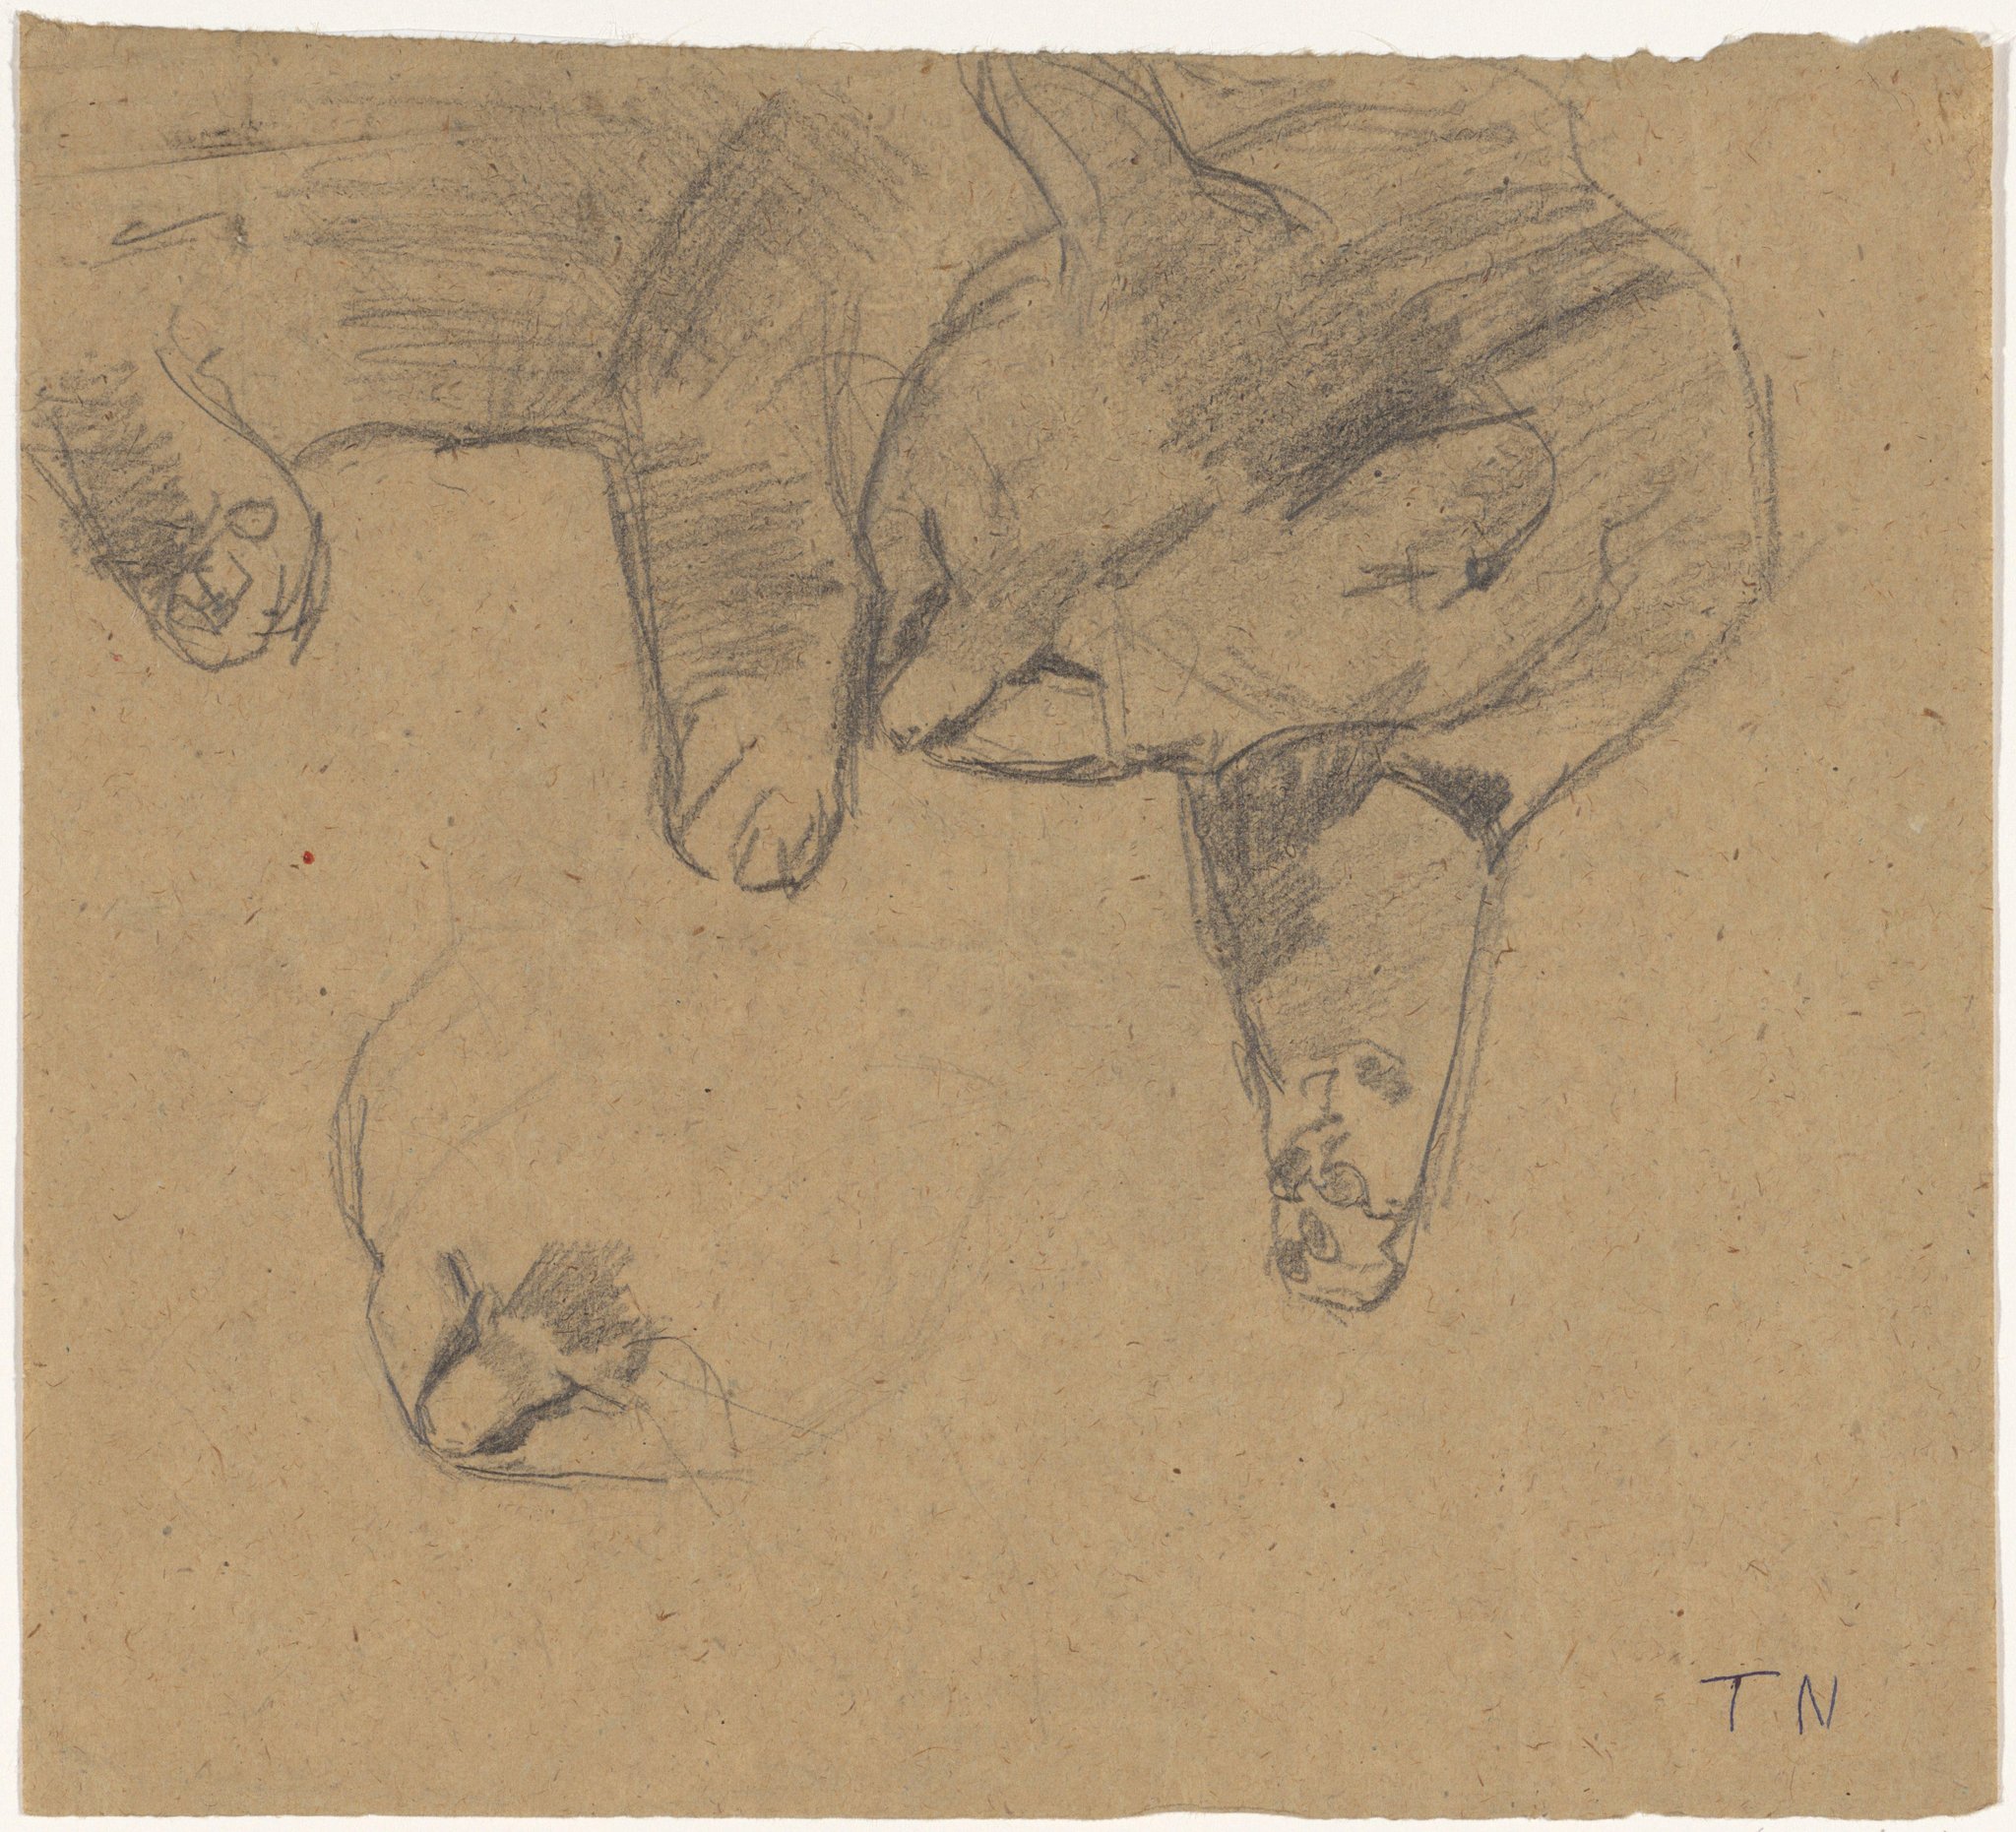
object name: drawing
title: Studies van een liggende kat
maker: theo nieuwenhuis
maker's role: designer, draughtsman, print maker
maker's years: 1866-1951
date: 1876-1951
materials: paper, pencil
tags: cat